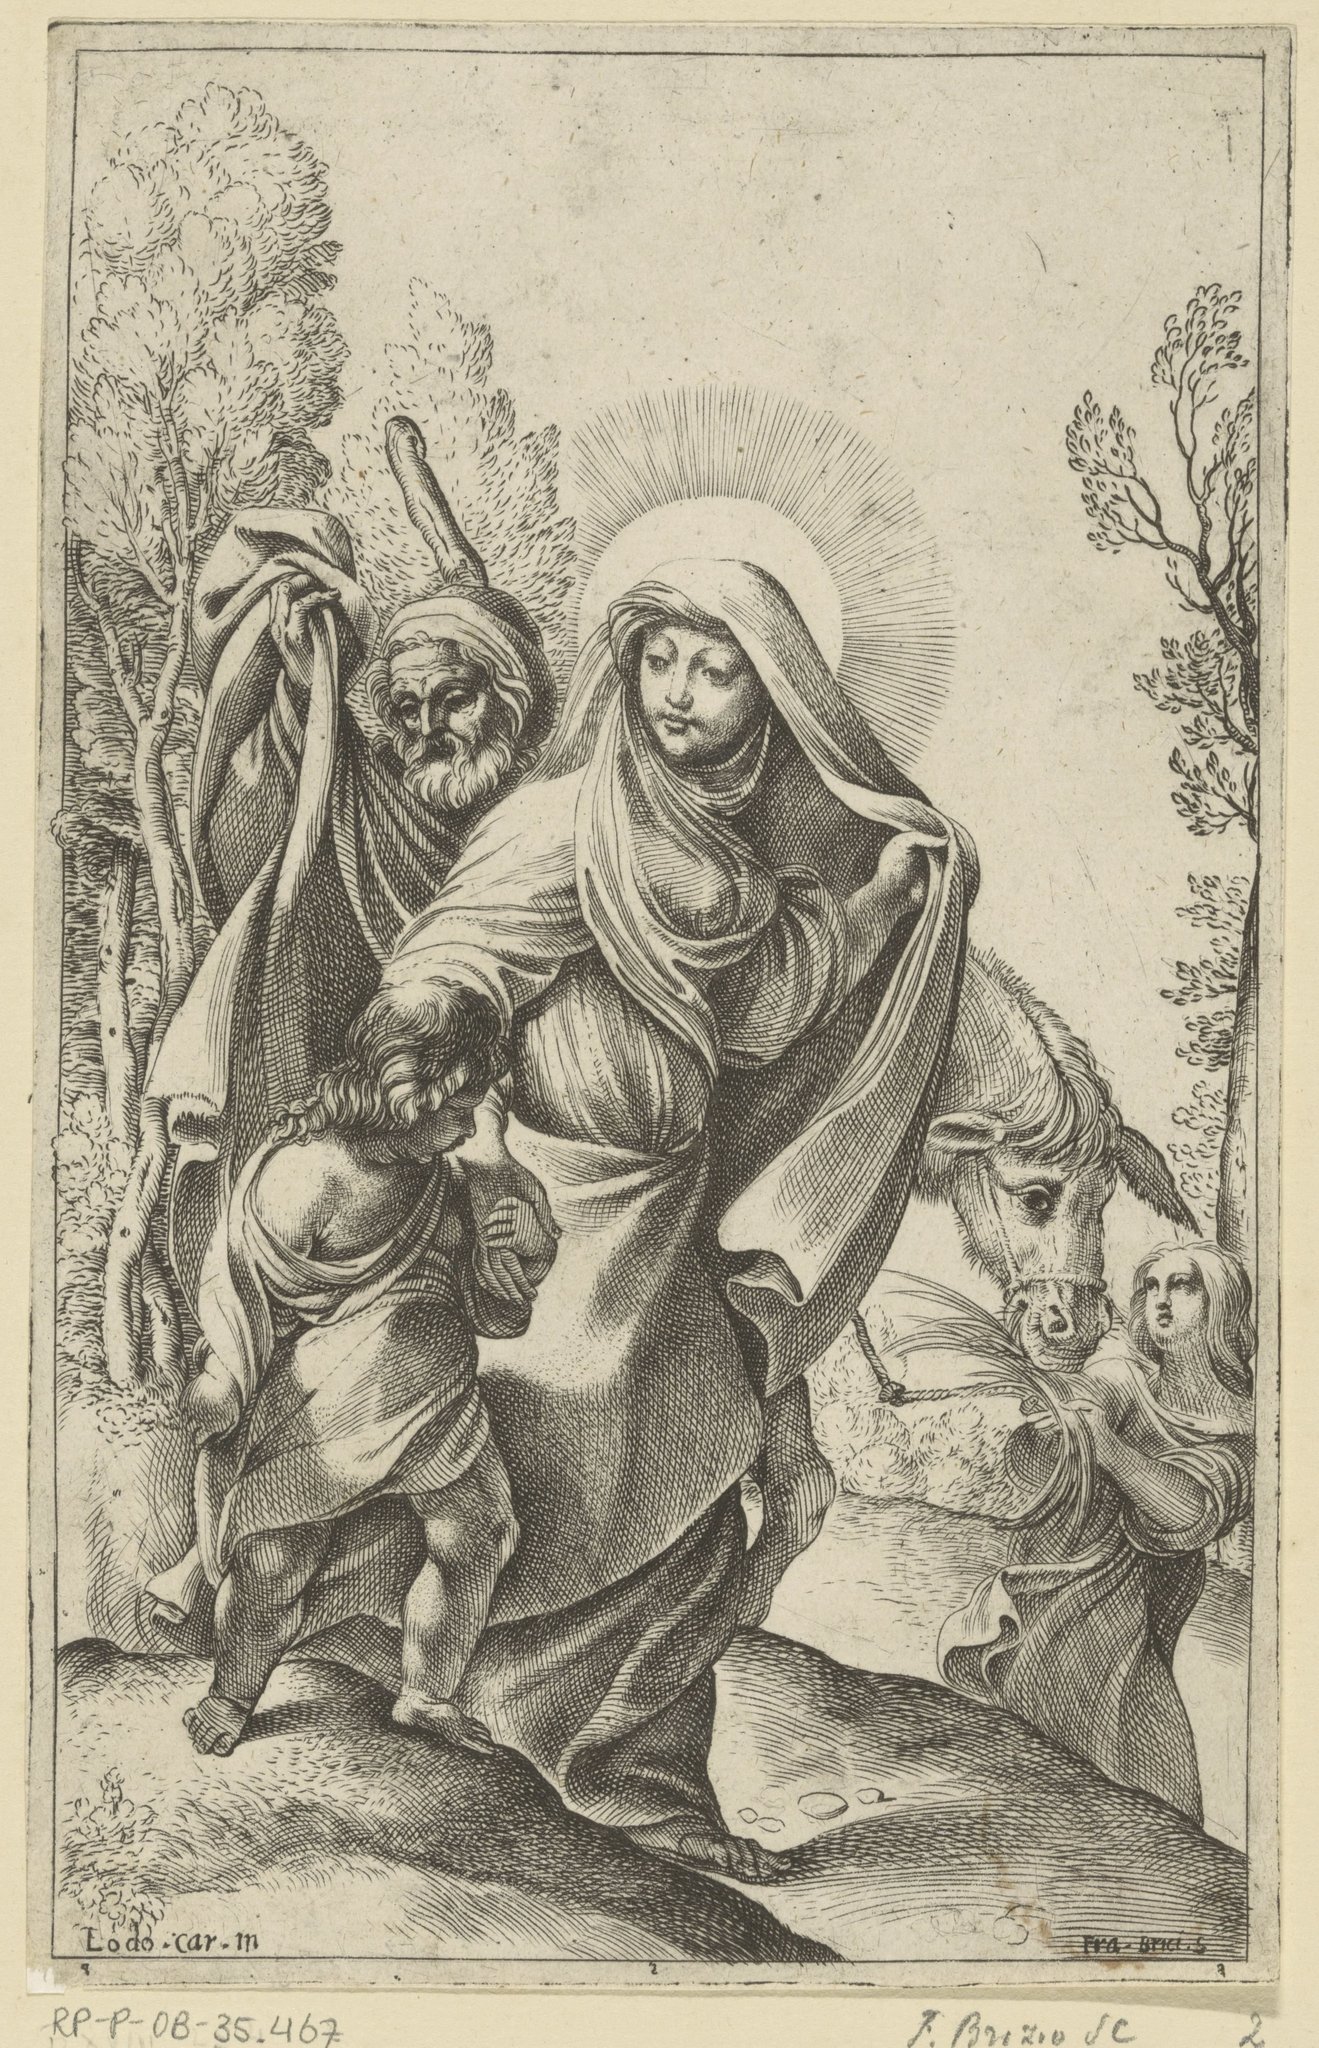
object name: print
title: Heilige Familie op de terugweg uit Egypte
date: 1584-1623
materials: paper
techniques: engraving, etching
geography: italy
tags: holy family, and derived representations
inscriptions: collector's mark: Lugt 240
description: Jozef, Maria en het Christuskind zijn samen met een dienstmeid en een ezel op de terugweg uit Egypte.